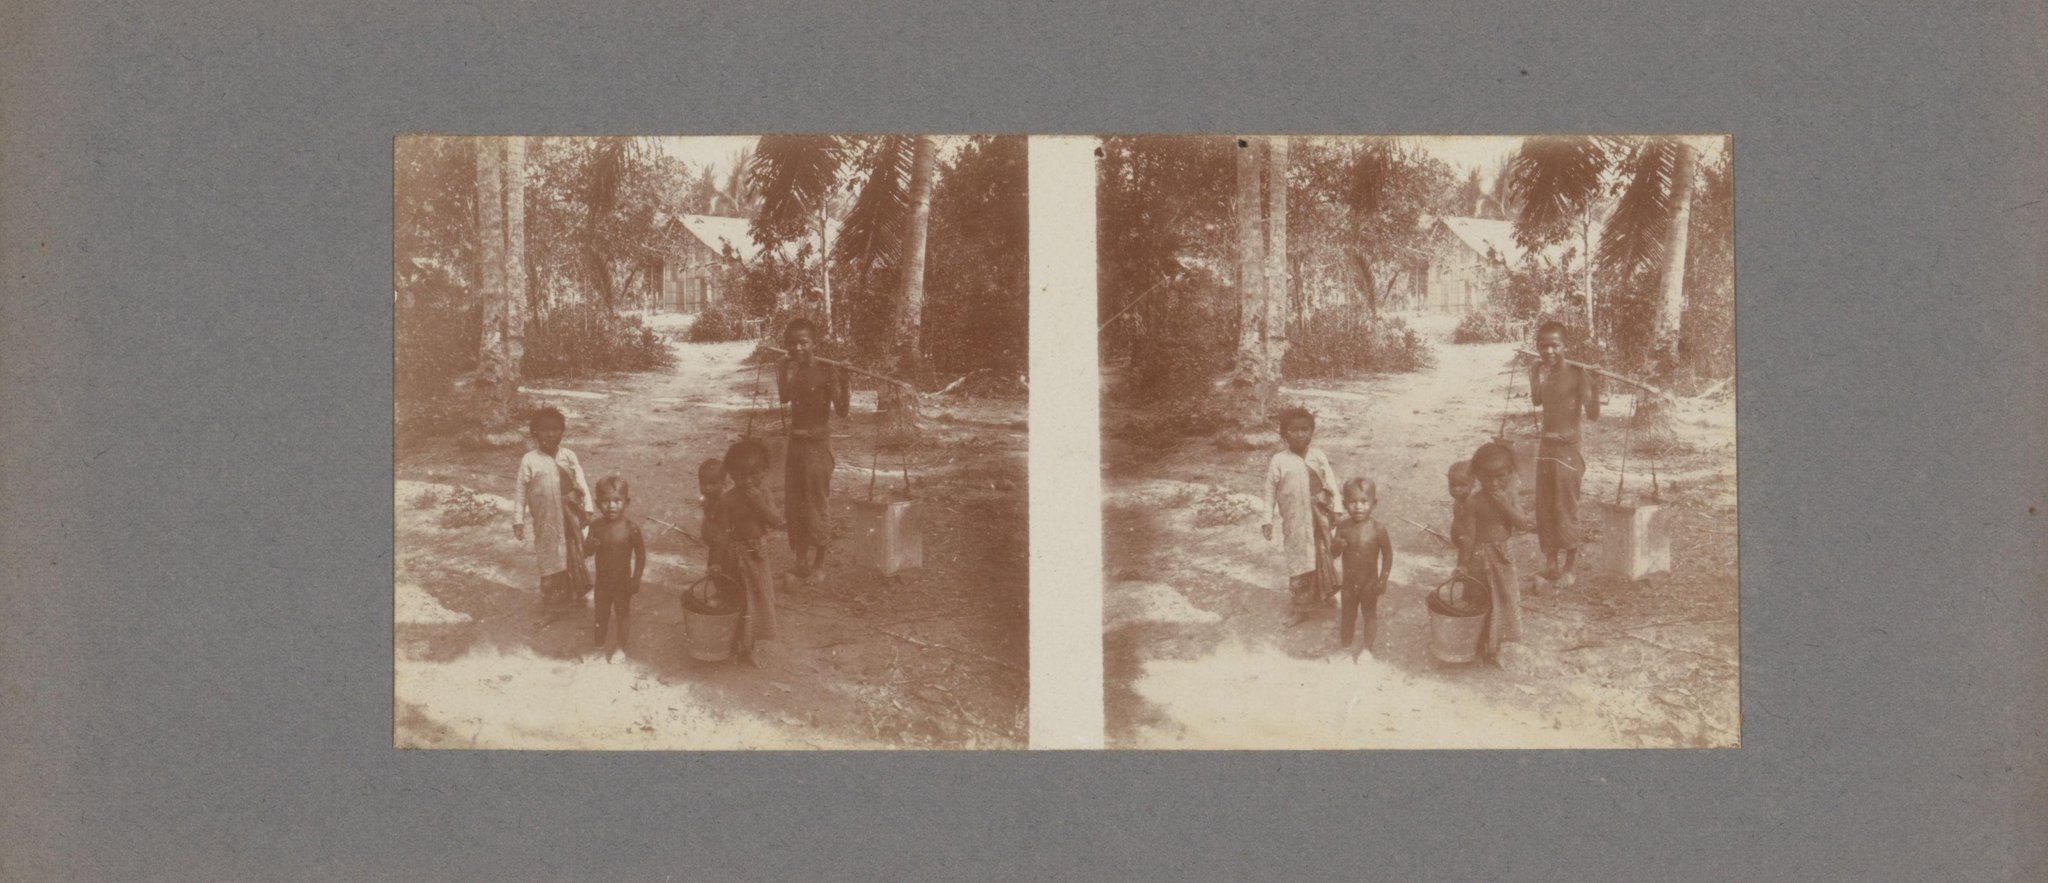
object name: stereograph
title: Kinderen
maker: robert julius boers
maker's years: 1867-1932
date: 1900-1922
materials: cardboard, photographic support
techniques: gelatin silver print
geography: bangka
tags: robert julius boers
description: Indische kinderen op een weg bij een dorp, waarschijnlijk te Banka. Onderdeel van een groep stereofoto's van Robert Julius Boers, chef van het staatsbedrijf de Banka-tinwinning op Banka, uit de periode ca. 1900-1922.